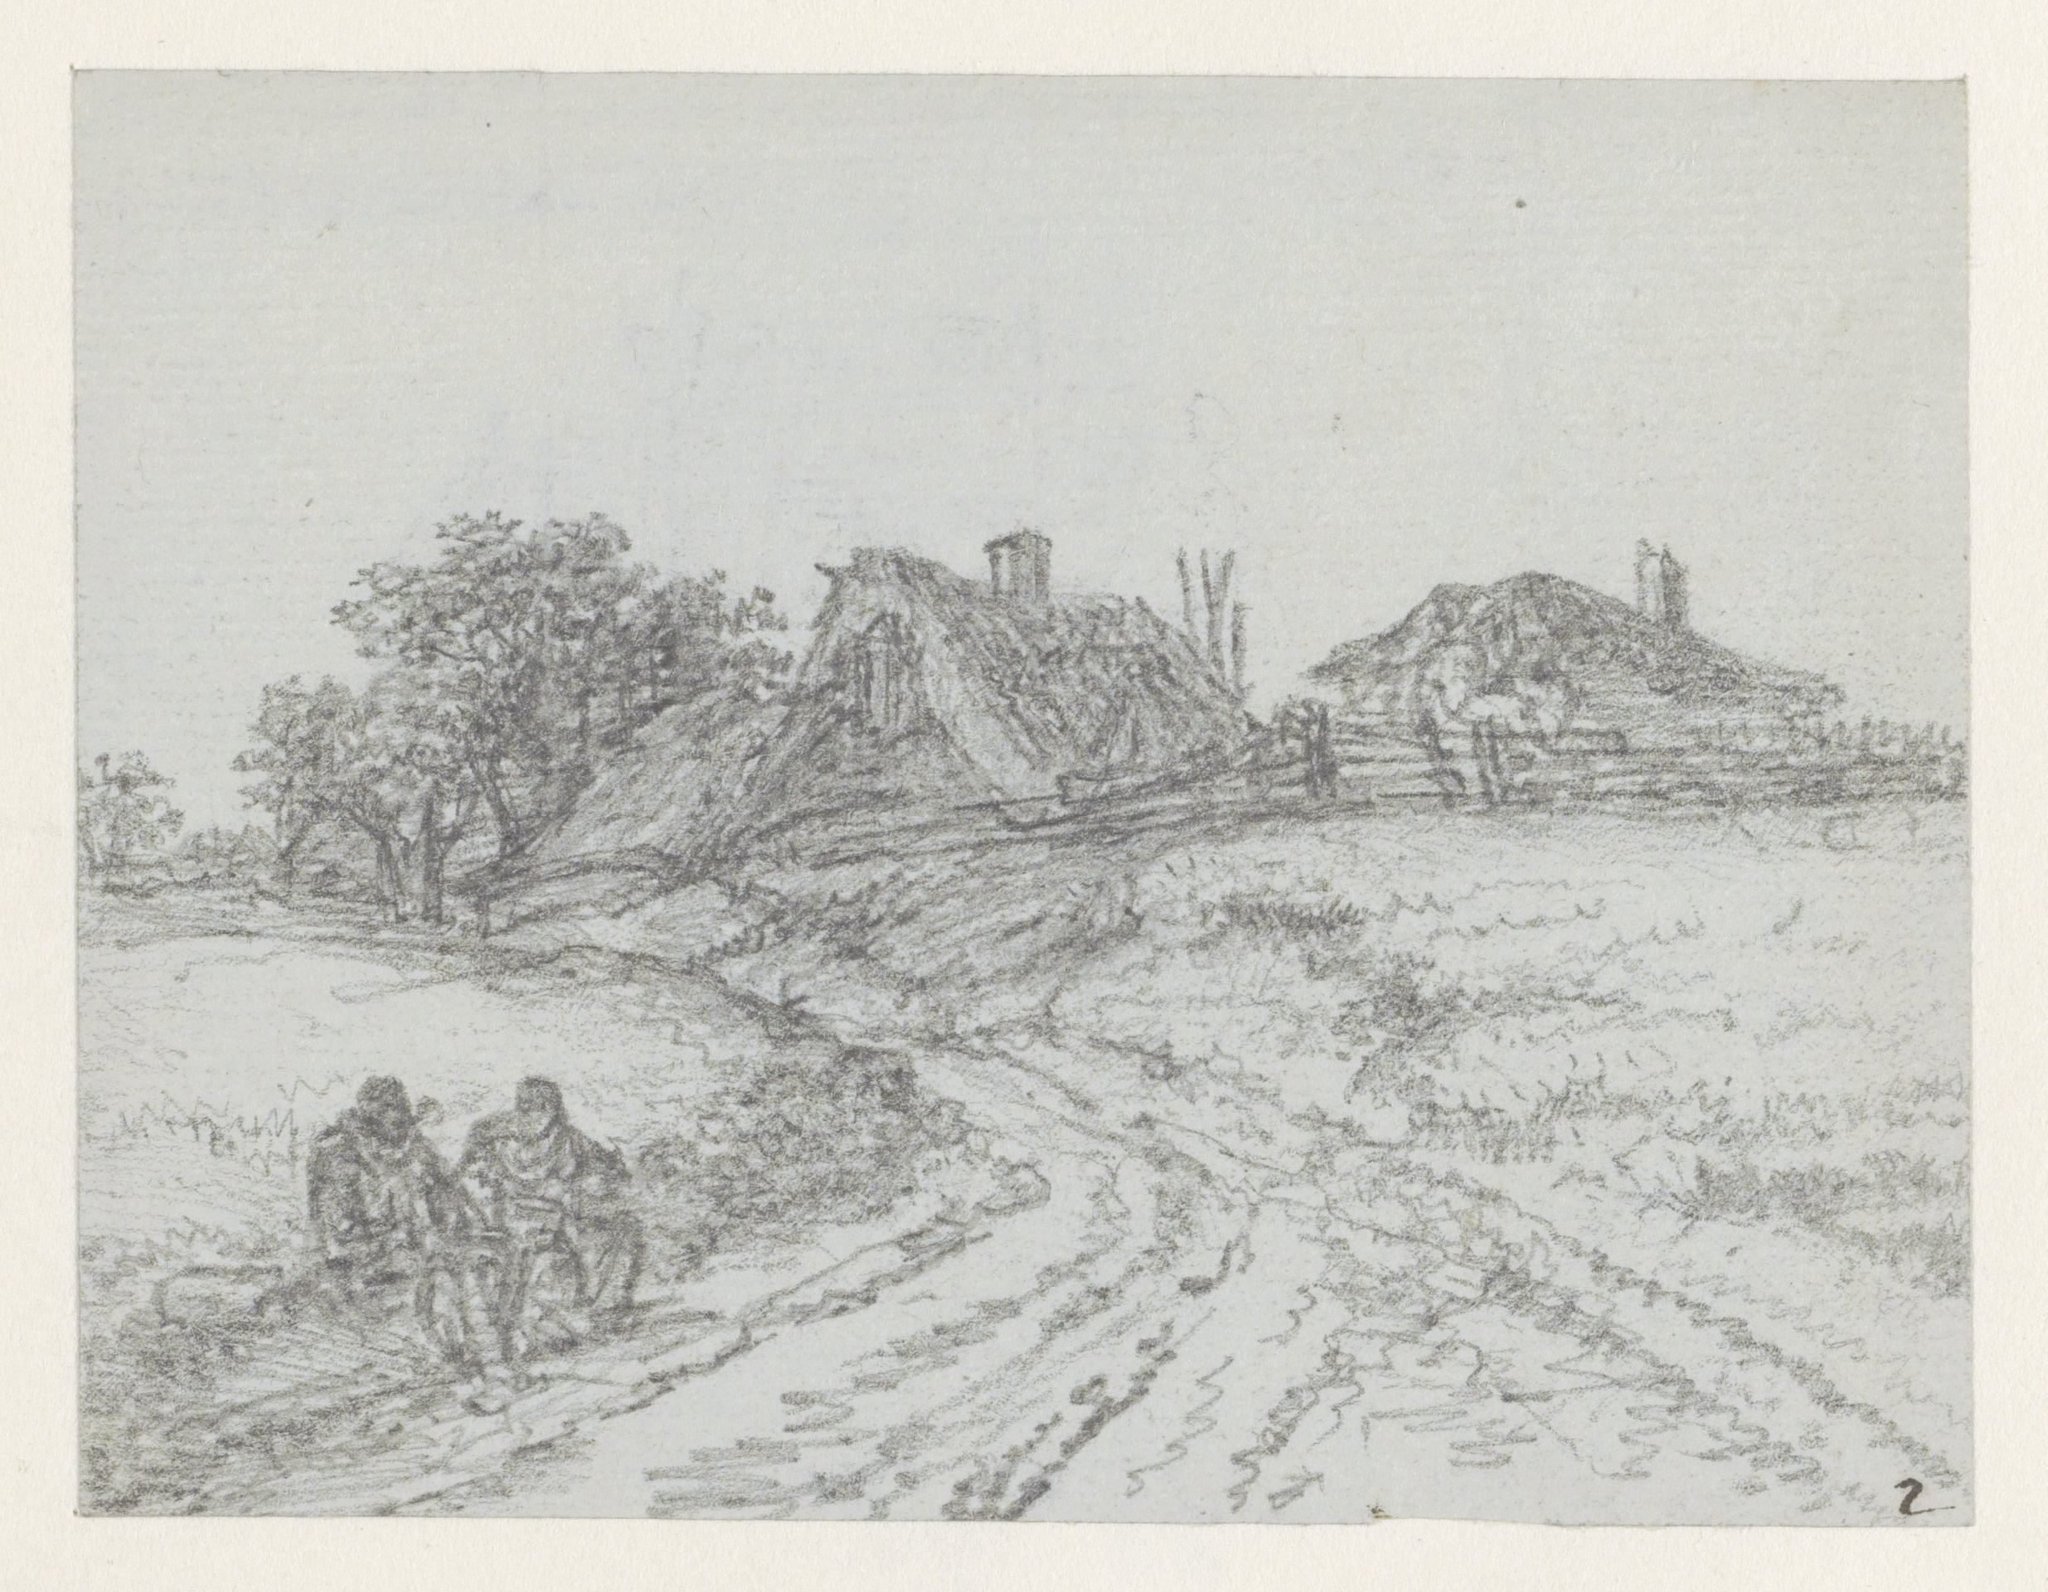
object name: drawing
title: Landweg naar een boerderij; links twee zittende boeren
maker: georges michel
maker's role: draughtsman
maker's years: 1763-1843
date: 1773-1843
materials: paper, pencil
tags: farm or solitary house in landscape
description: Een van 120 tekeningen, afkomstig uit een 19e eeuws album met tekeningen van Georges Michel.